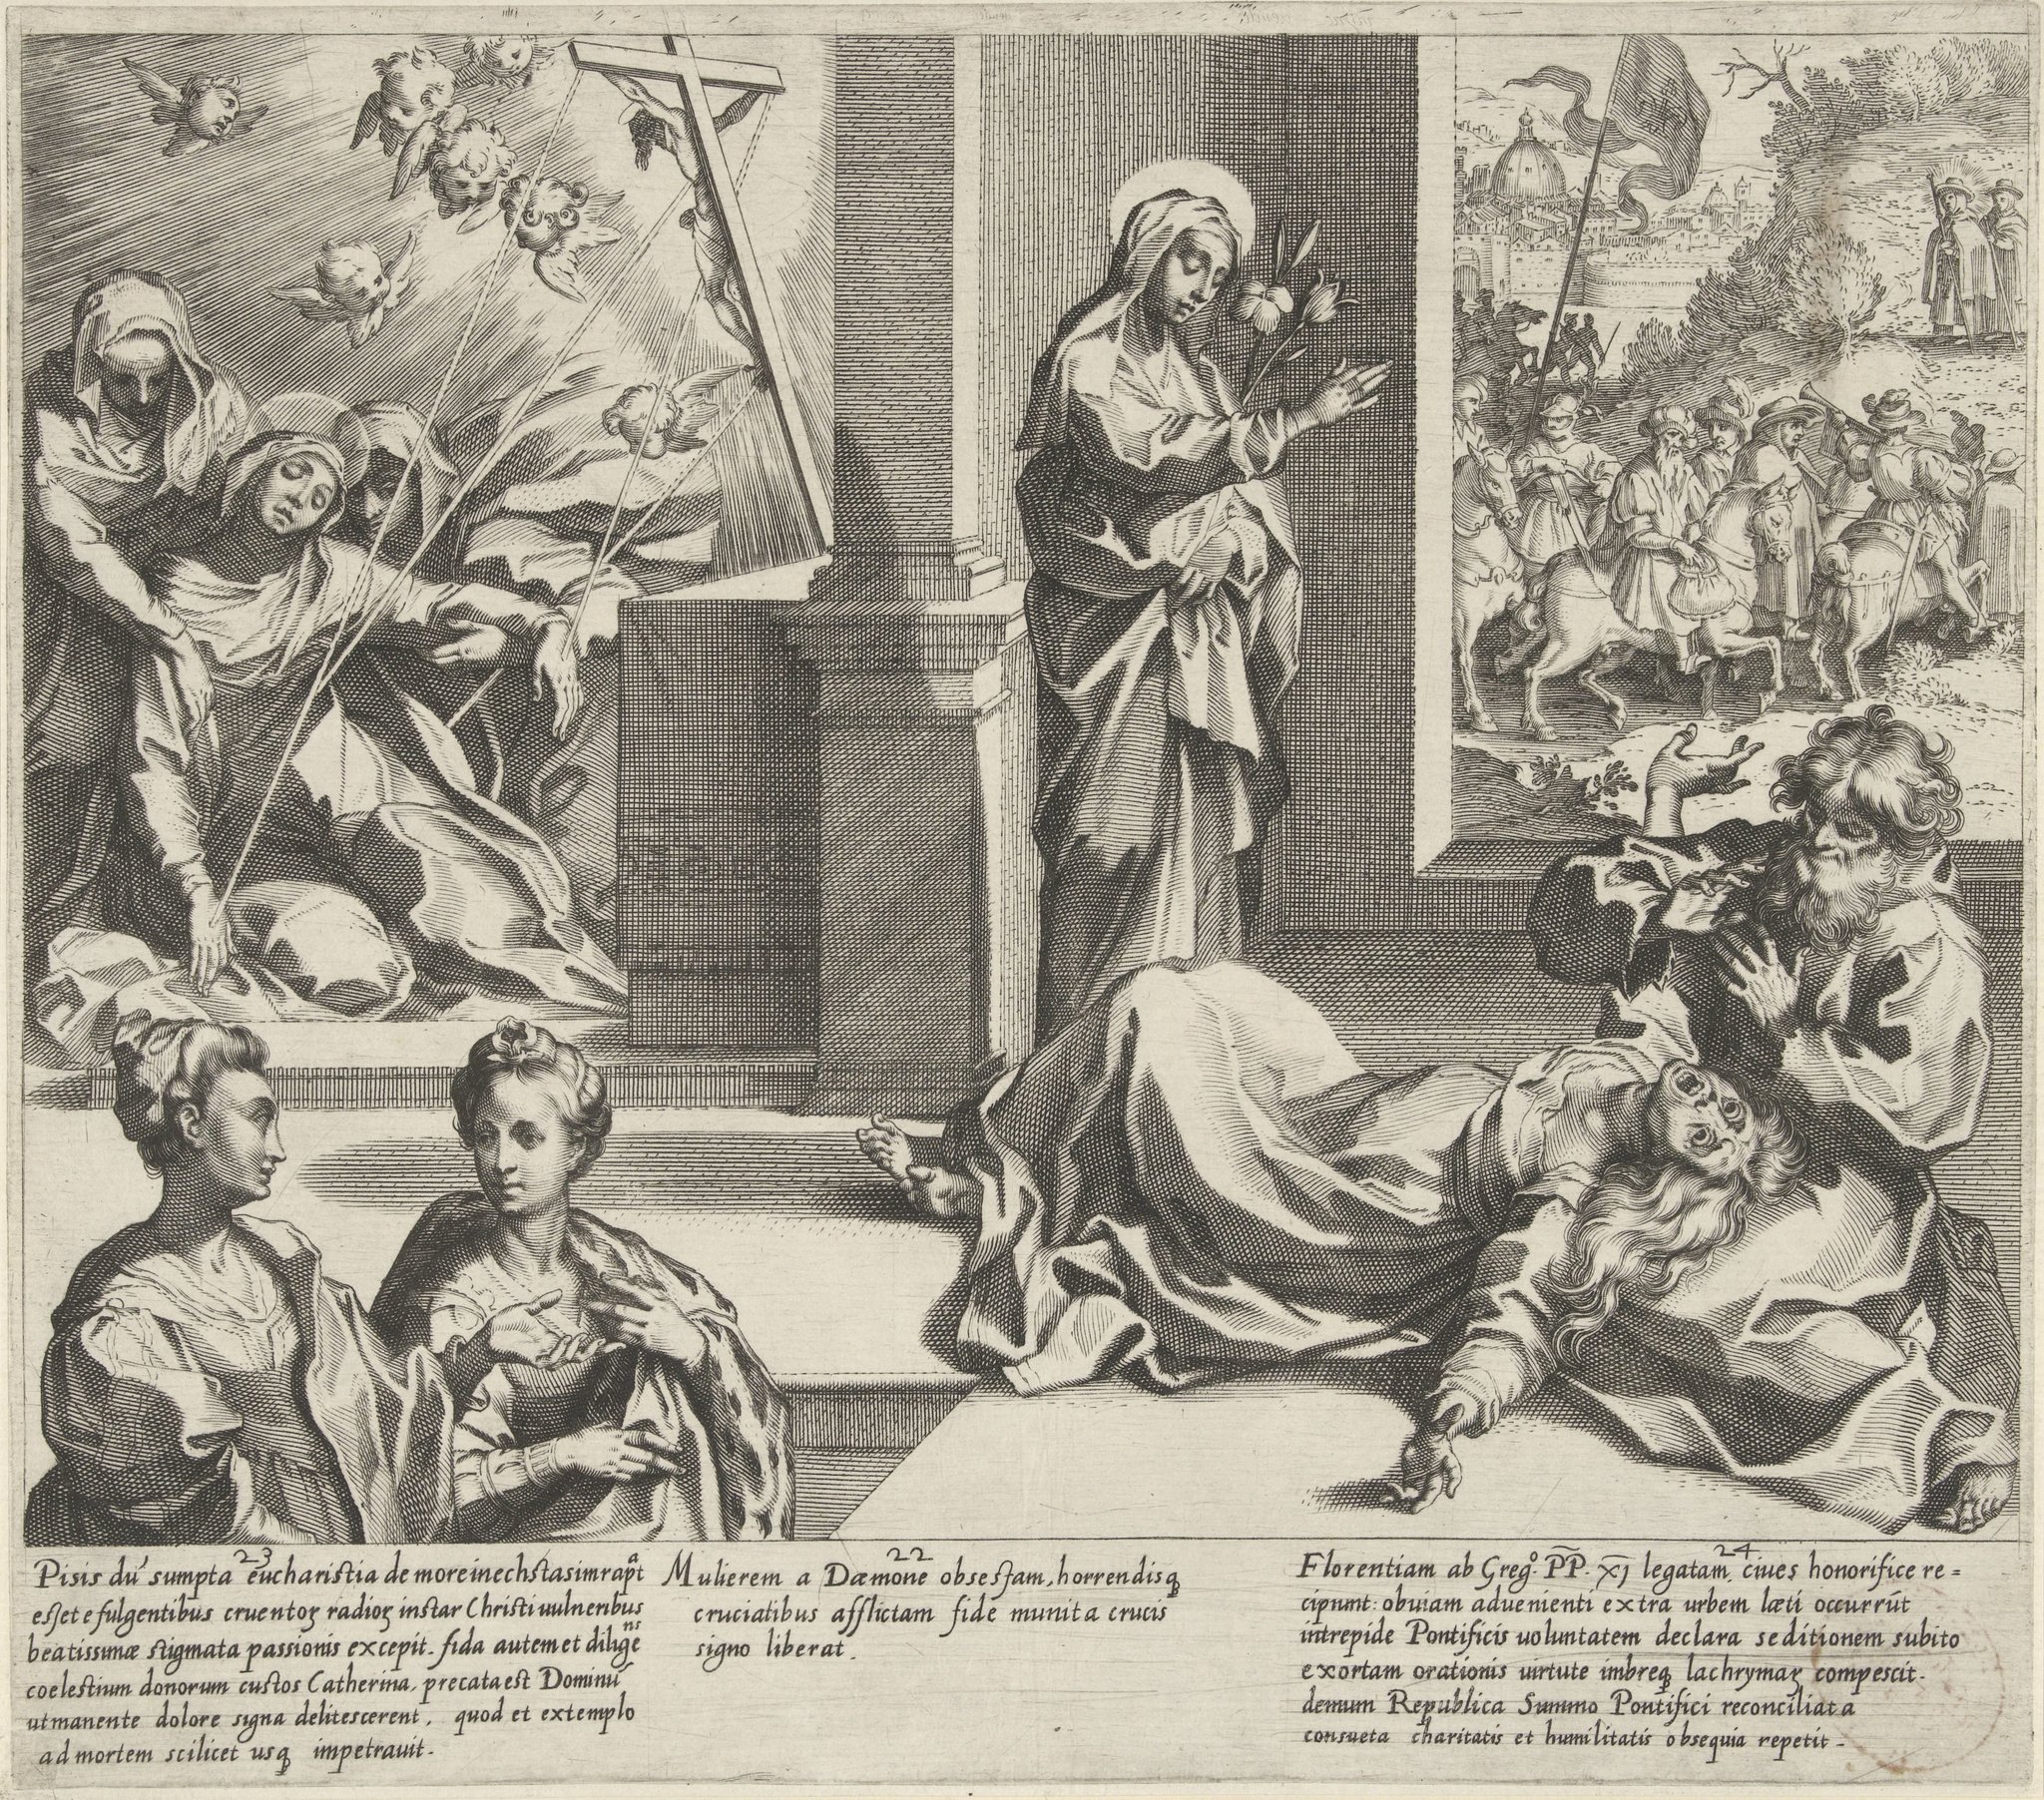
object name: print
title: Scènes uit het leven en wonderen van de Heilige Catharina van Siena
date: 1597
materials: paper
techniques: engraving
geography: italy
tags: the virgin and dominican tertiary, catherine of siena; possible attributes: book, cross, crown of thorns, crucifix, demon under foot, heart (with cross), lily, plague-stricken, ring, rosary, stigmata, st. catherine of siena, kneeling before a crucifix, or swooning into the arms of two nuns, receives the stigmata, pope gregory xi returns from avignon to rome after a visit from st. catherine of siena, miraculous healings of st. catherine of siena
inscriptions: collector's mark: Lugt 240